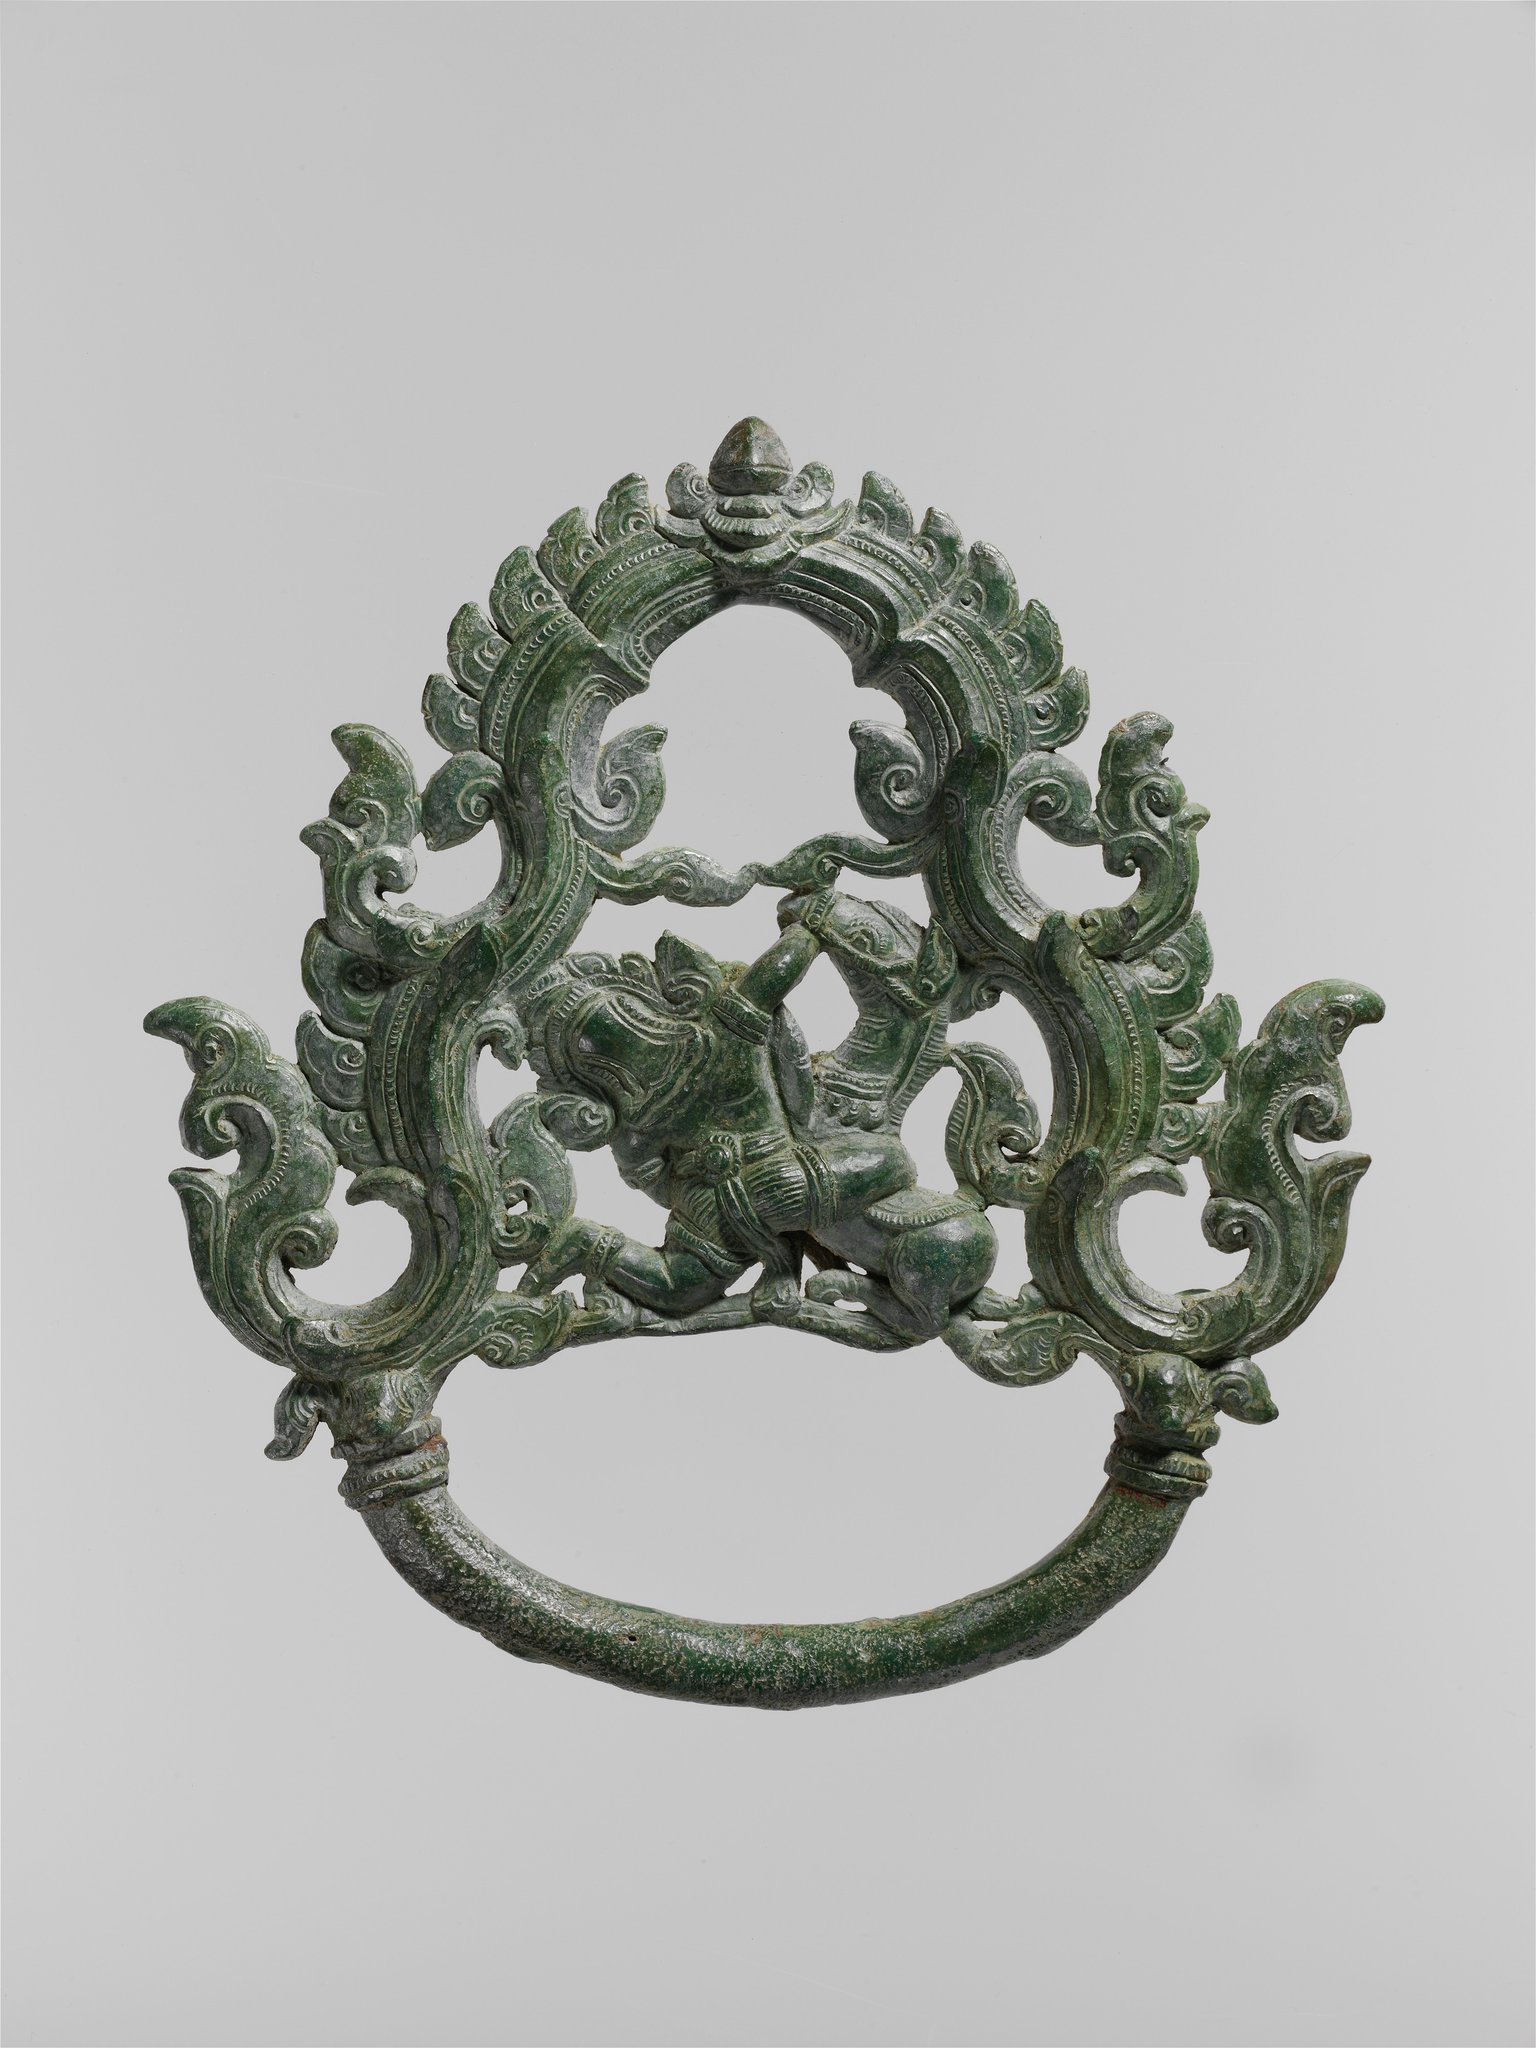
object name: palanquin ring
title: Palanquin Ring with a Demon Battling a Horse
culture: cambodian or thai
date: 1201-1233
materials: bronze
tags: horses,demons